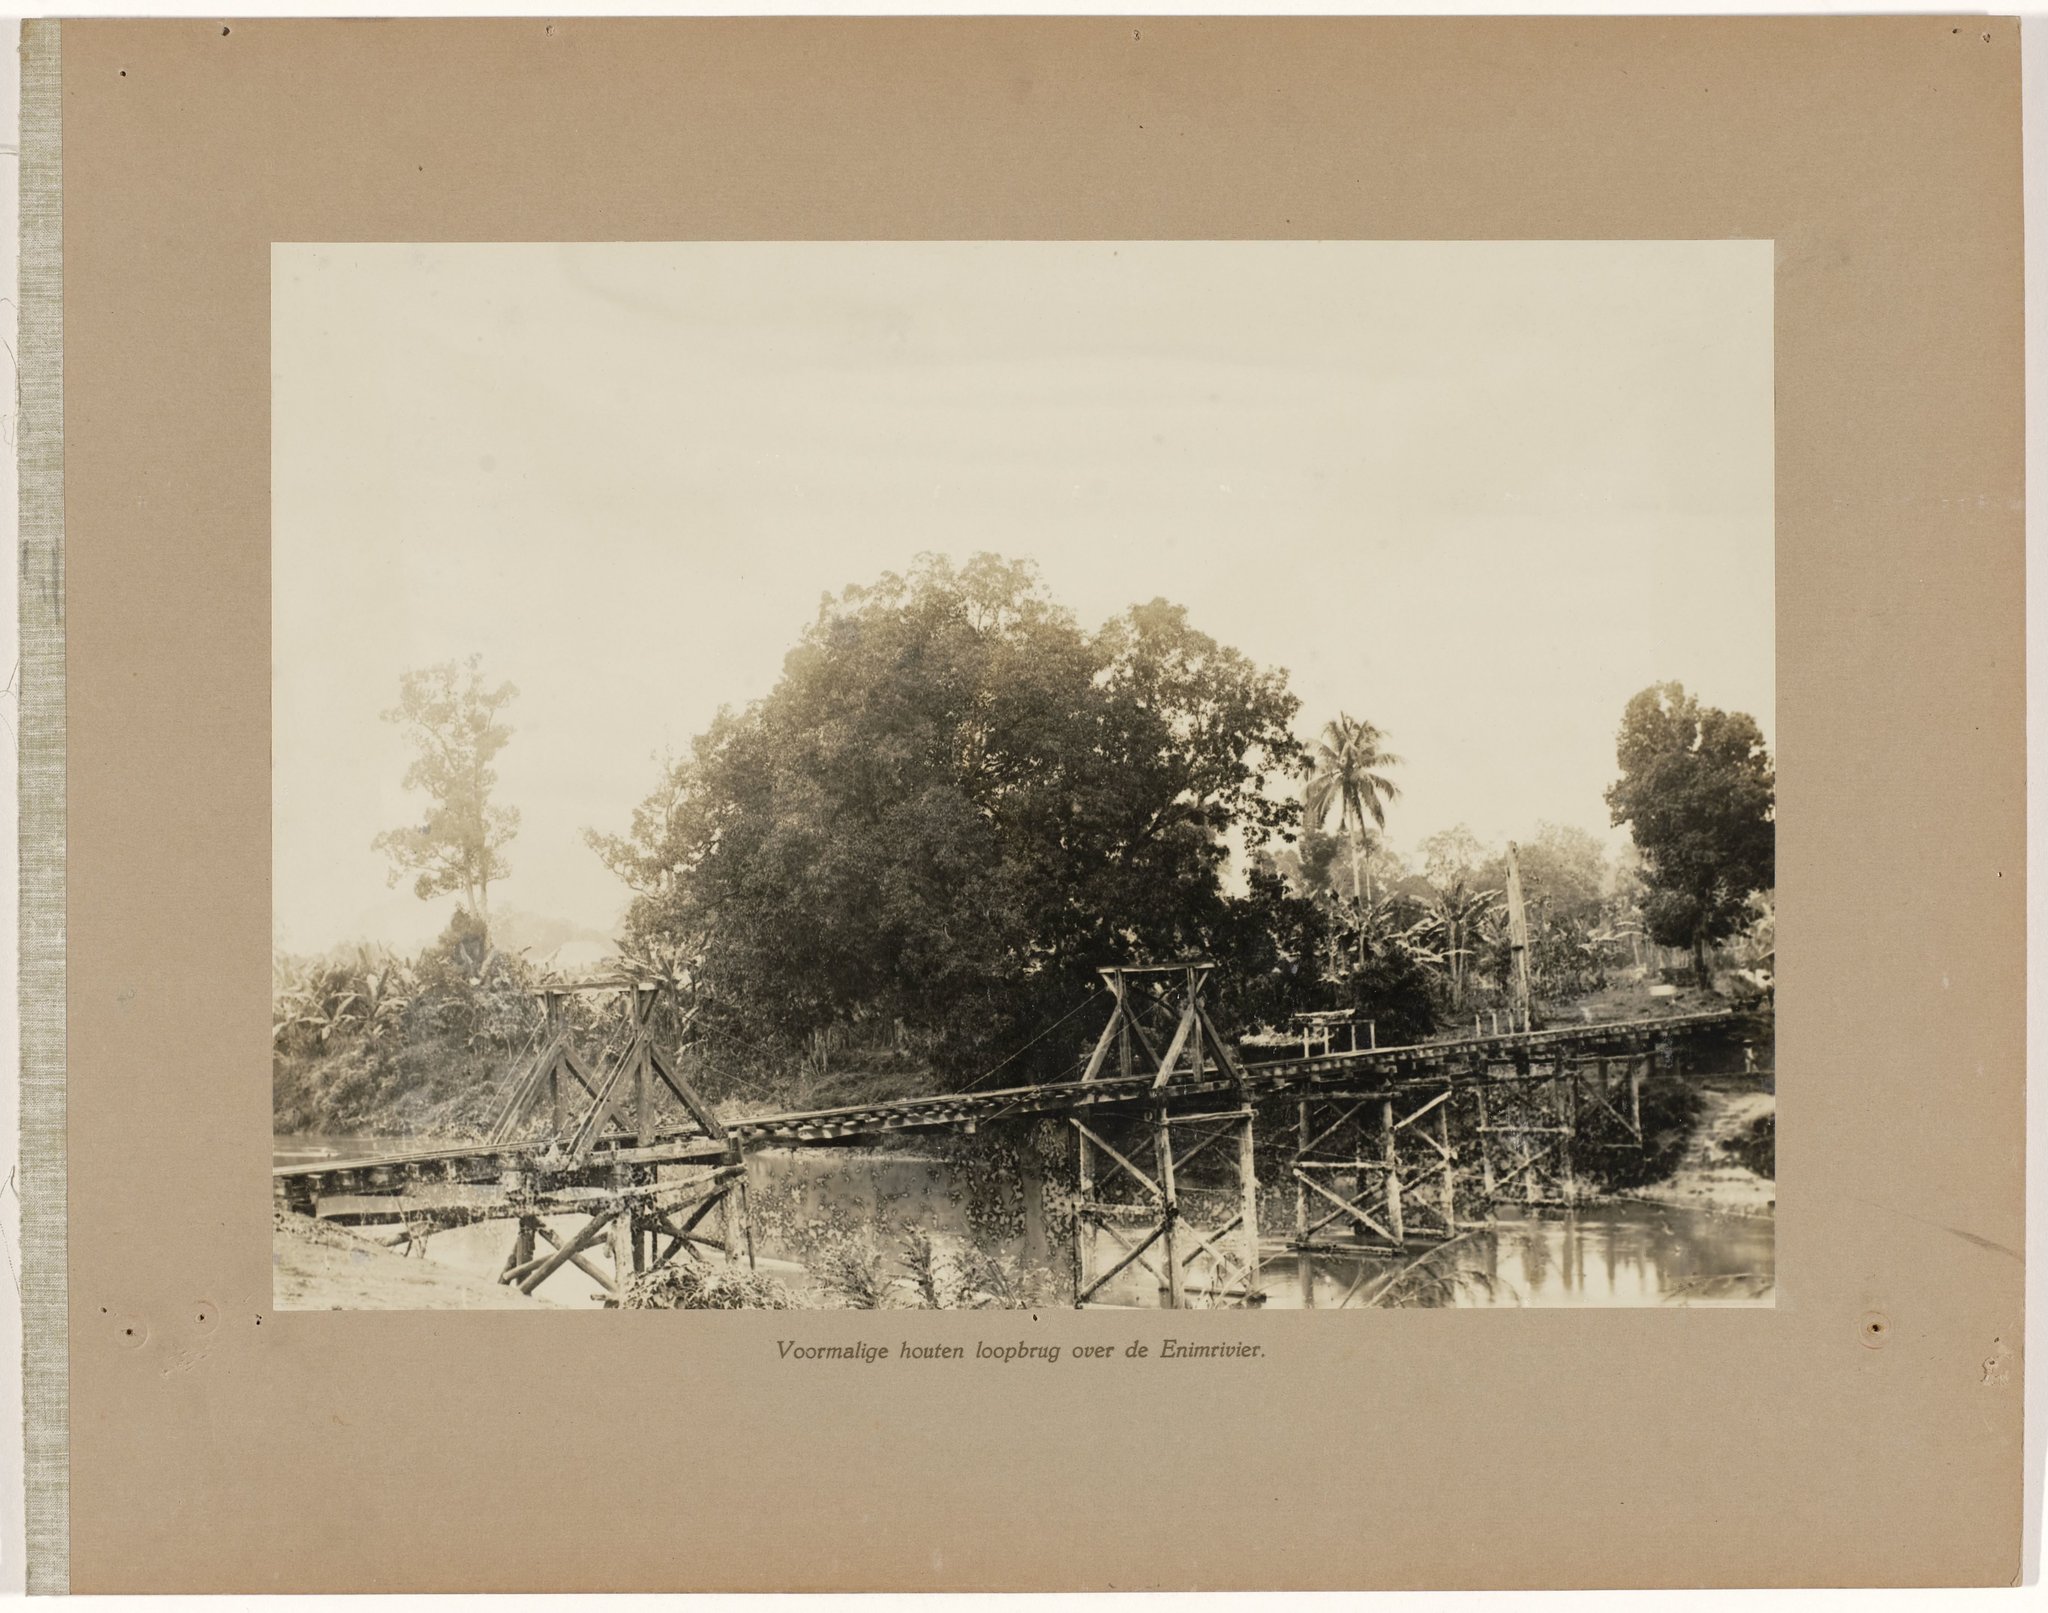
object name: photograph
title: Voormalige houten loopbrug over de Enimrivier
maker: Anonymous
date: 1921-1922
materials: photographic support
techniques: gelatin silver print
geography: bukit asam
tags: colonial system, anthracite, hard coal, opencast mine; strip mining (+ coal), bridge, sumatra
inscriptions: inscription: ‘Voormalige houten loopbrug over de Enimrivier.’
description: Gezicht op de oude houten loopbrug over de rivier Air Enim, nabij de mijn. Onderdeel van het losbladige fotoalbum aangeboden door het personeel van de Boekit-Asam Steenkolenmijnen op Sumatra aan de scheidende Ingenieur-Directeur H. Tromp op 7 januari 1922.